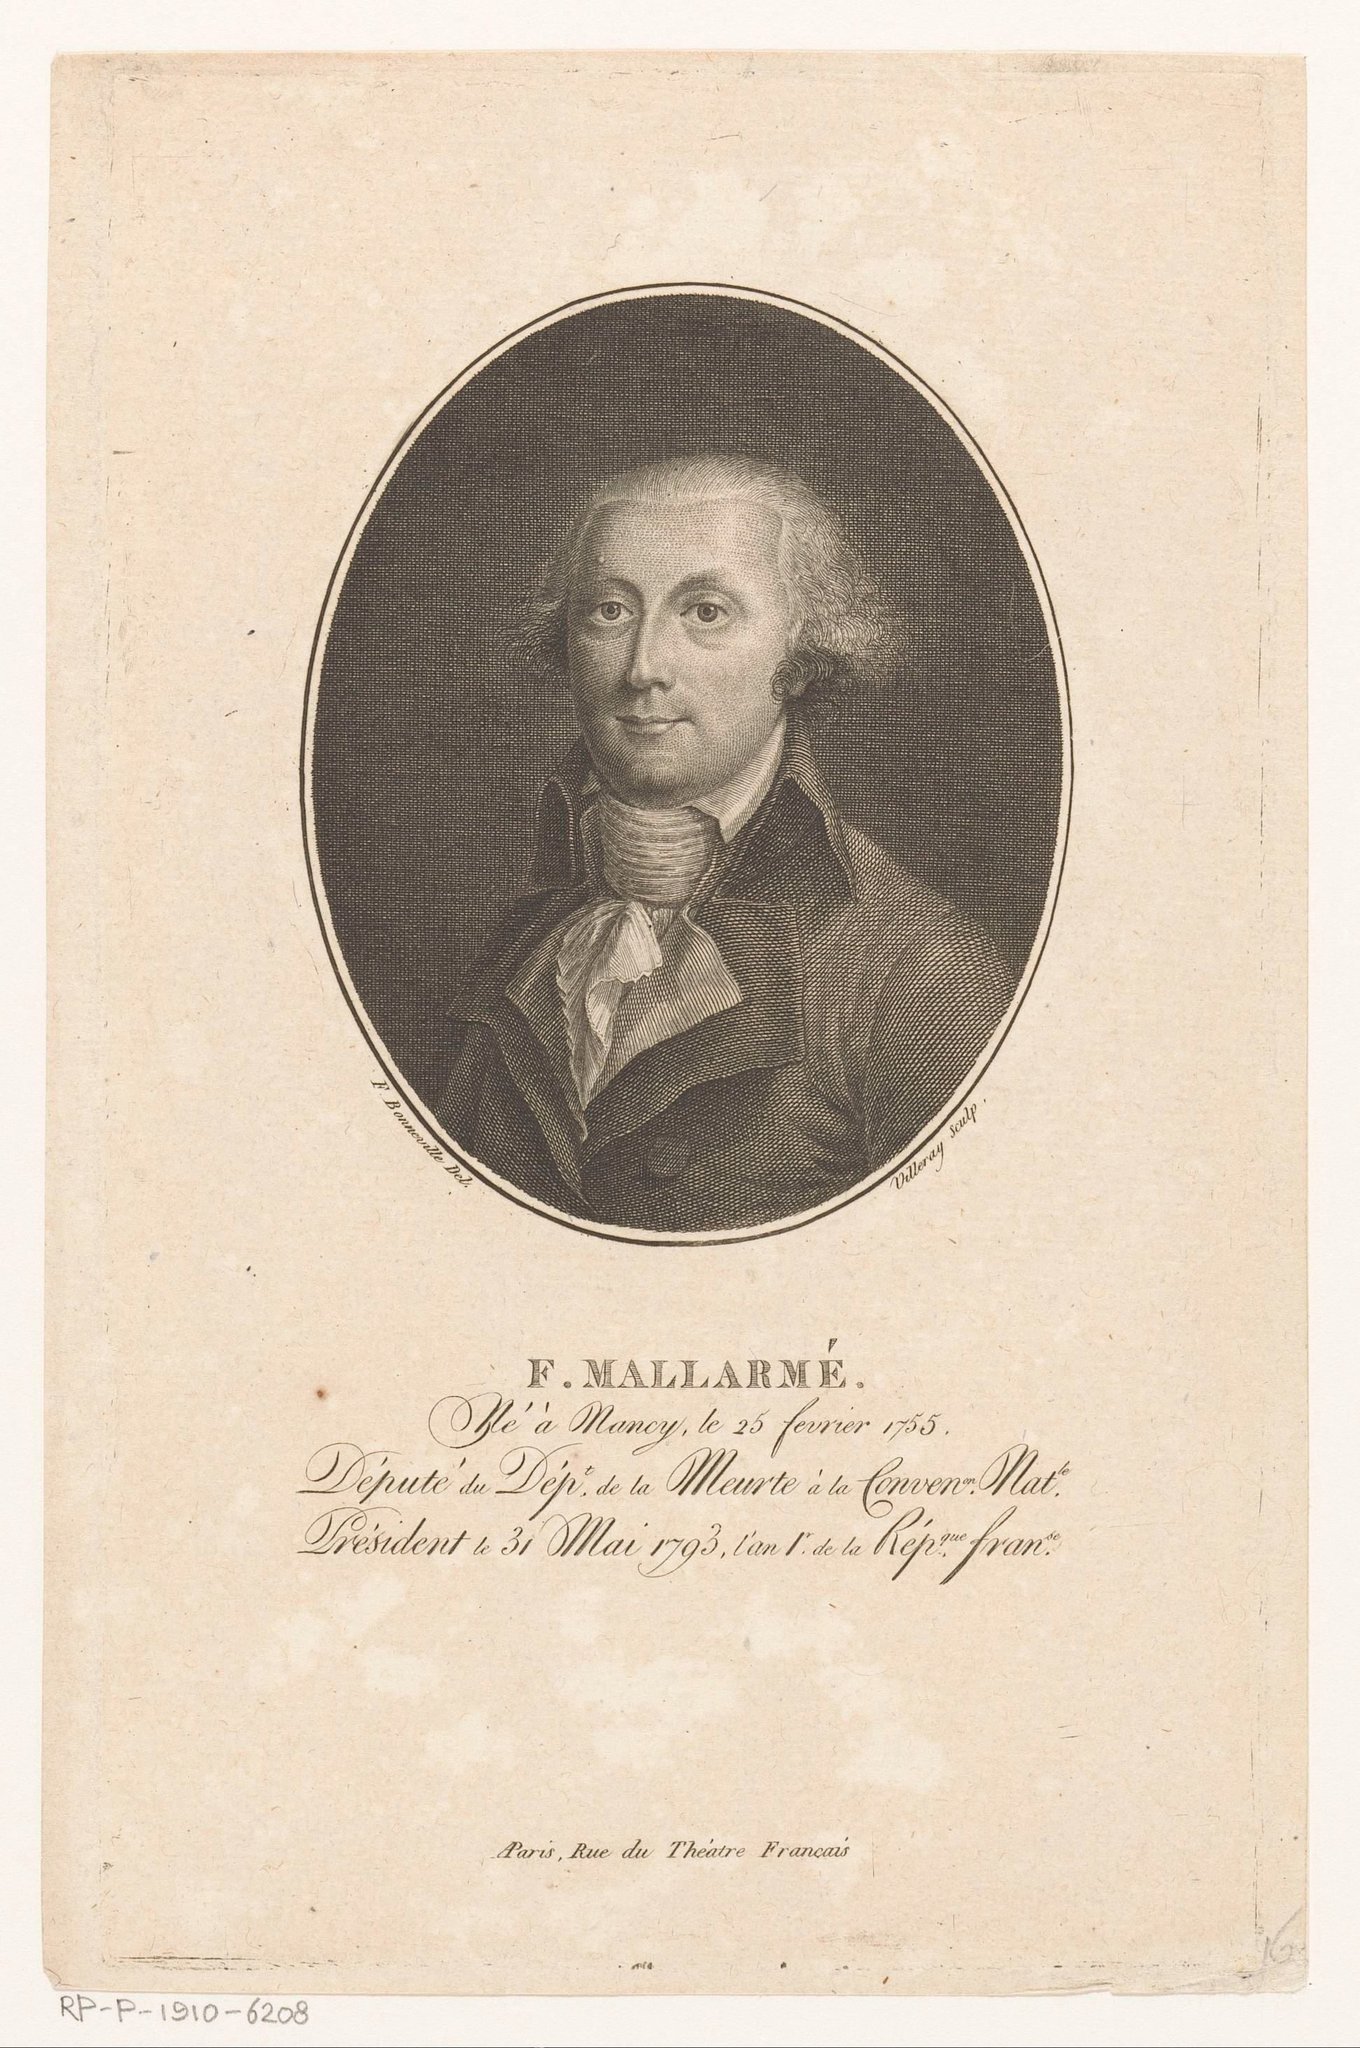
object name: print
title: Portret van François-René-Auguste Mallarmé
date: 1787-1810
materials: paper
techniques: engraving, etching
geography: paris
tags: official; civil servant; functionary (in general), historical persons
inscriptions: collector's mark: Lugt 2228